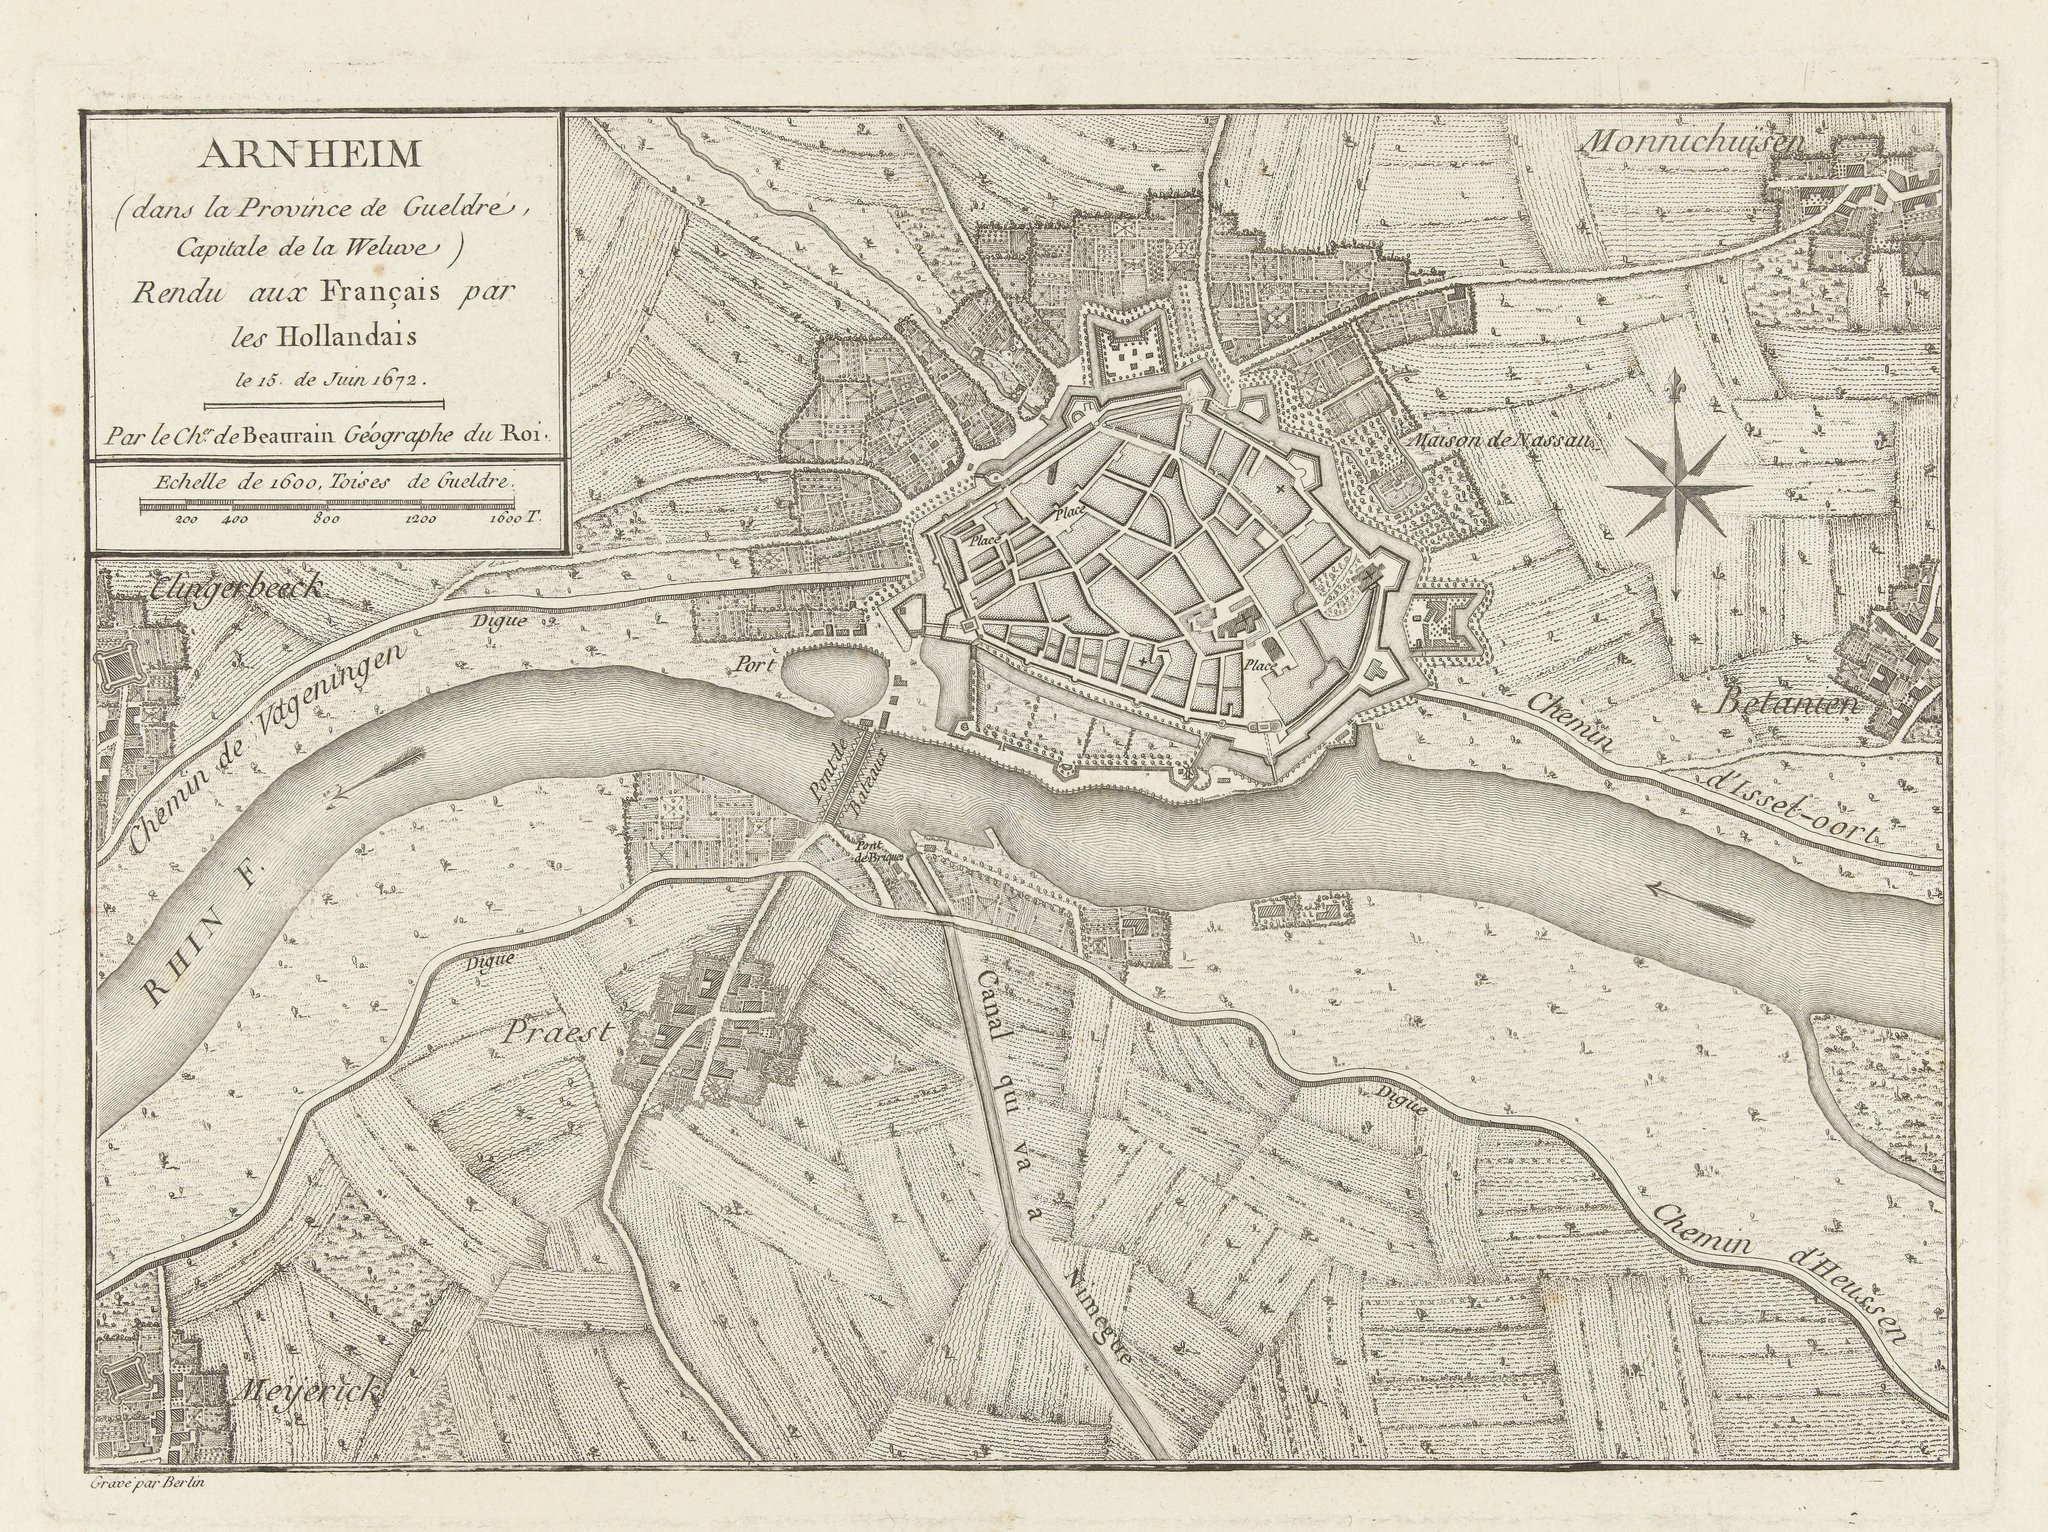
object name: print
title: Arnheim (dans la Province de Gueldre, Capitale de la Weluve) Rendu aux Français par les Hollandais le 15. de Juin 1672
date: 1780-1782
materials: paper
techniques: etching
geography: france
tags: maps of cities, arnhem, rampjaar (disaster year)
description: Waarschijnlijk gebruikt als illustratie in: Philippe Henri, comte de Grimoard en Chevalier de Beaurain, Histoire des quatre dernieres campagnes du Marechal de Turenne, en 1672, 1673, 1674 & 1675..., Chevalier de Beaurain, Parijs 1782. Niet in Frederik Muller; door het RPK toegevoegd nummer.